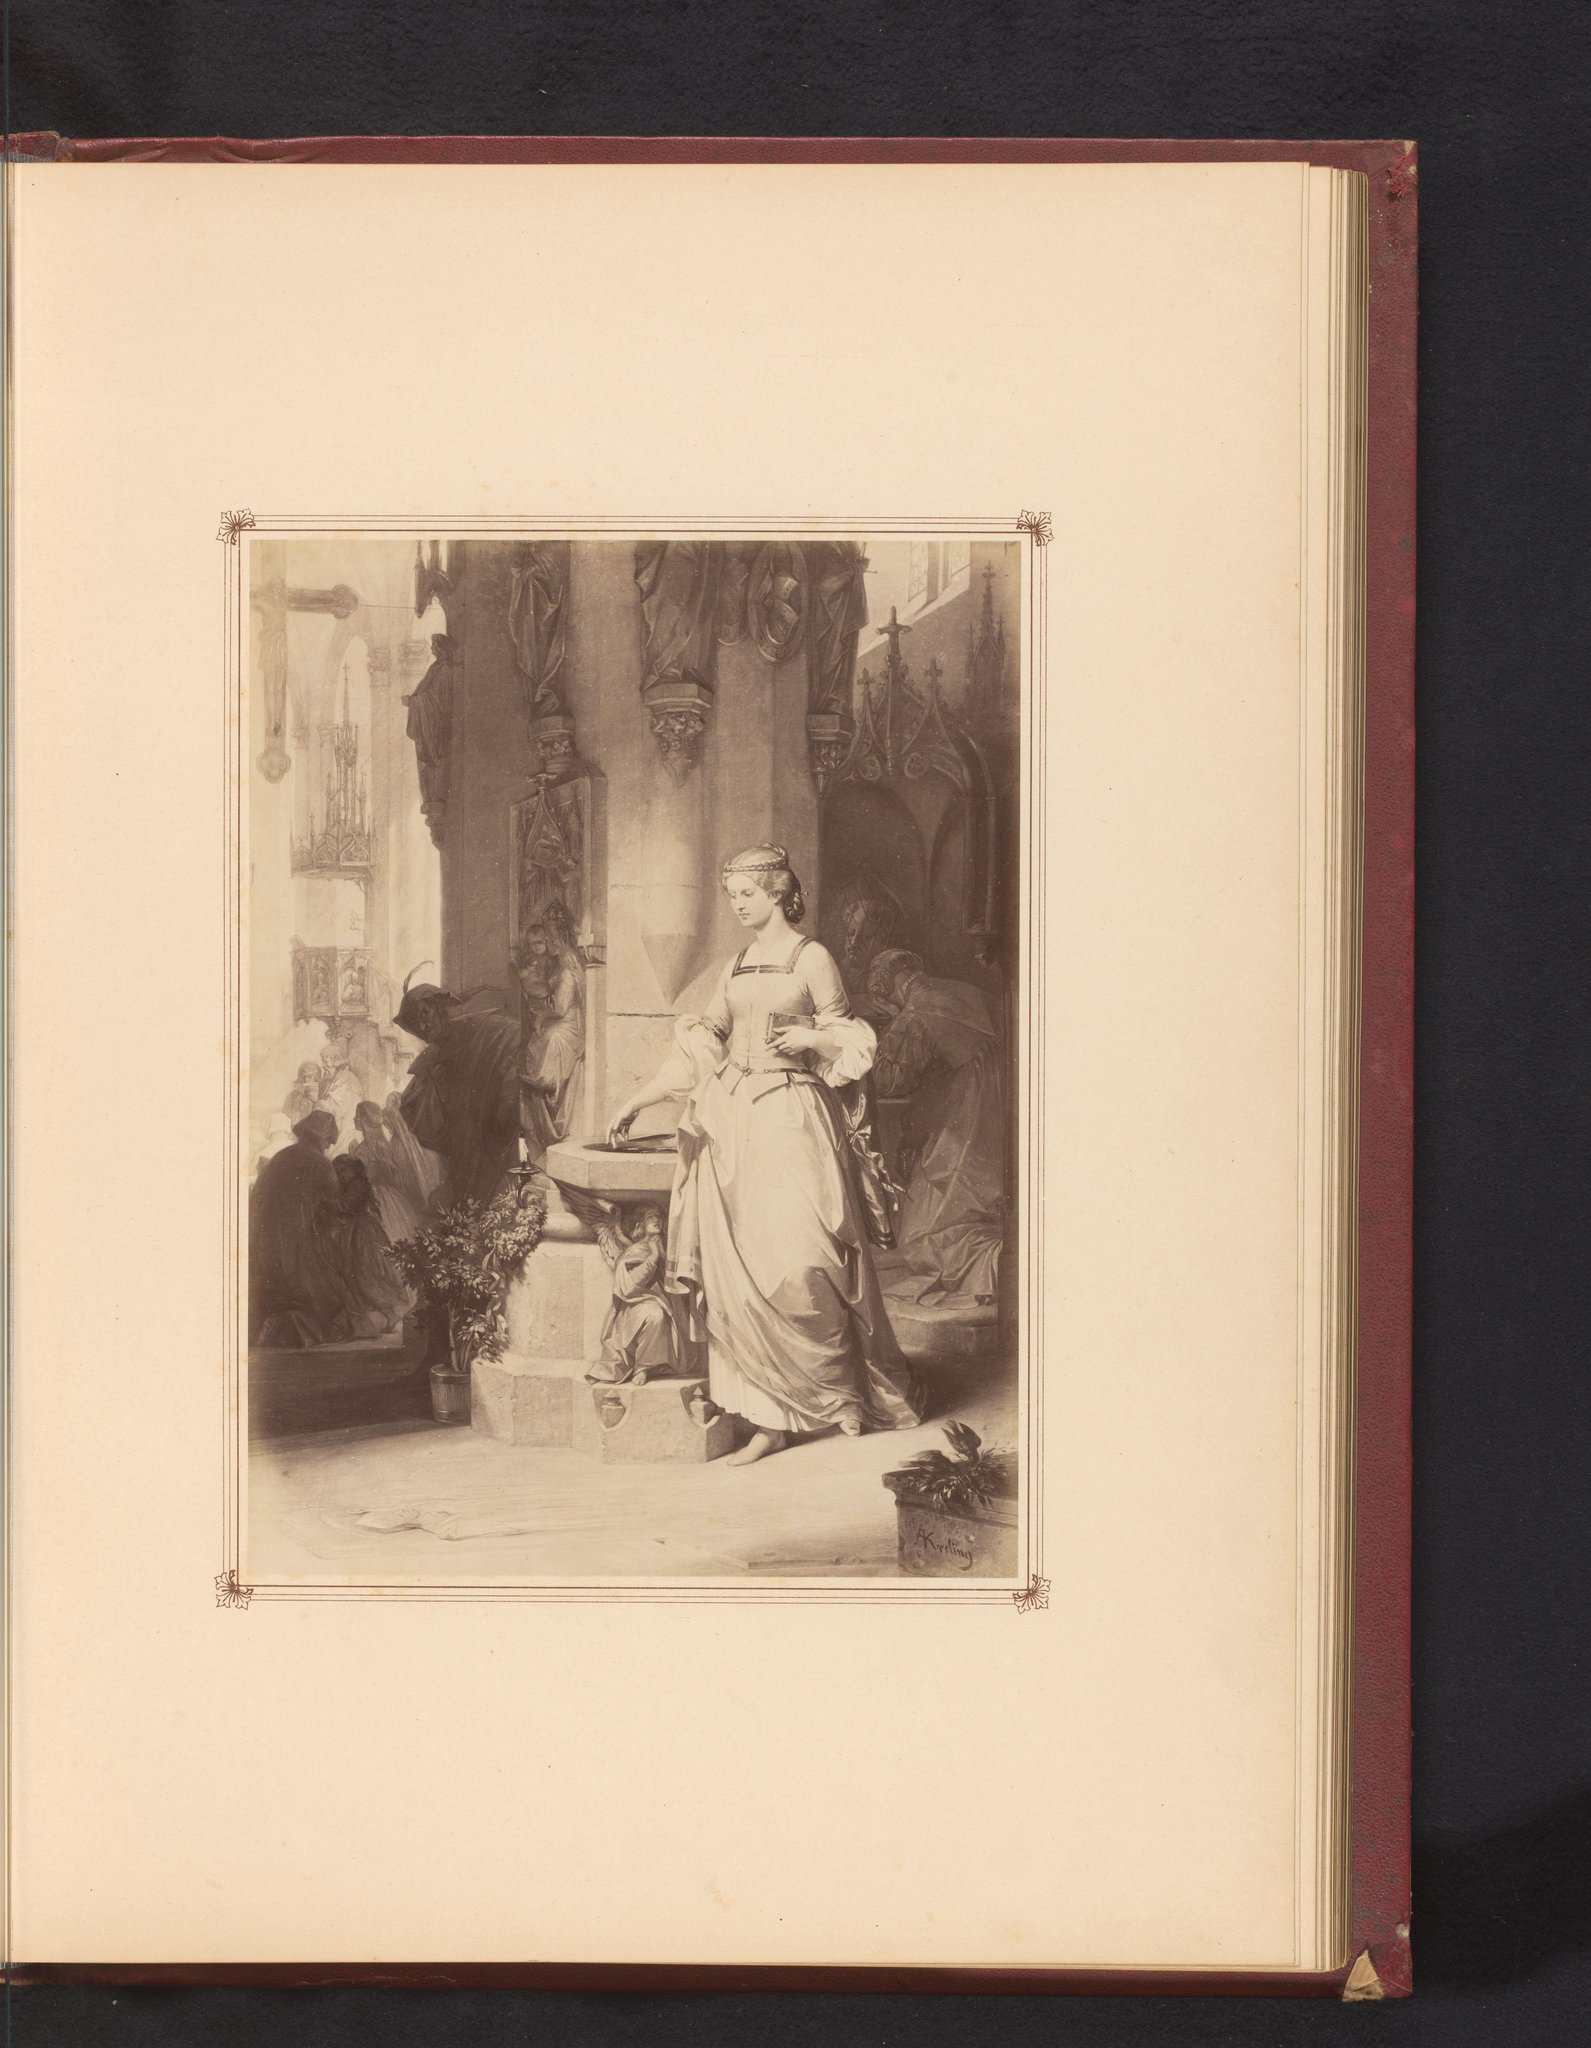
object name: photograph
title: Fotoreproductie van een tekening van Gretchen, uit het eerste deel van de tragedie Faust door Johann Wolfgang von Goethe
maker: friedrich bruckmann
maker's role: publisher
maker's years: 1814-1898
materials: photographic support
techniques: albumen print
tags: (scenes from) specific works of literature: goethe, faust